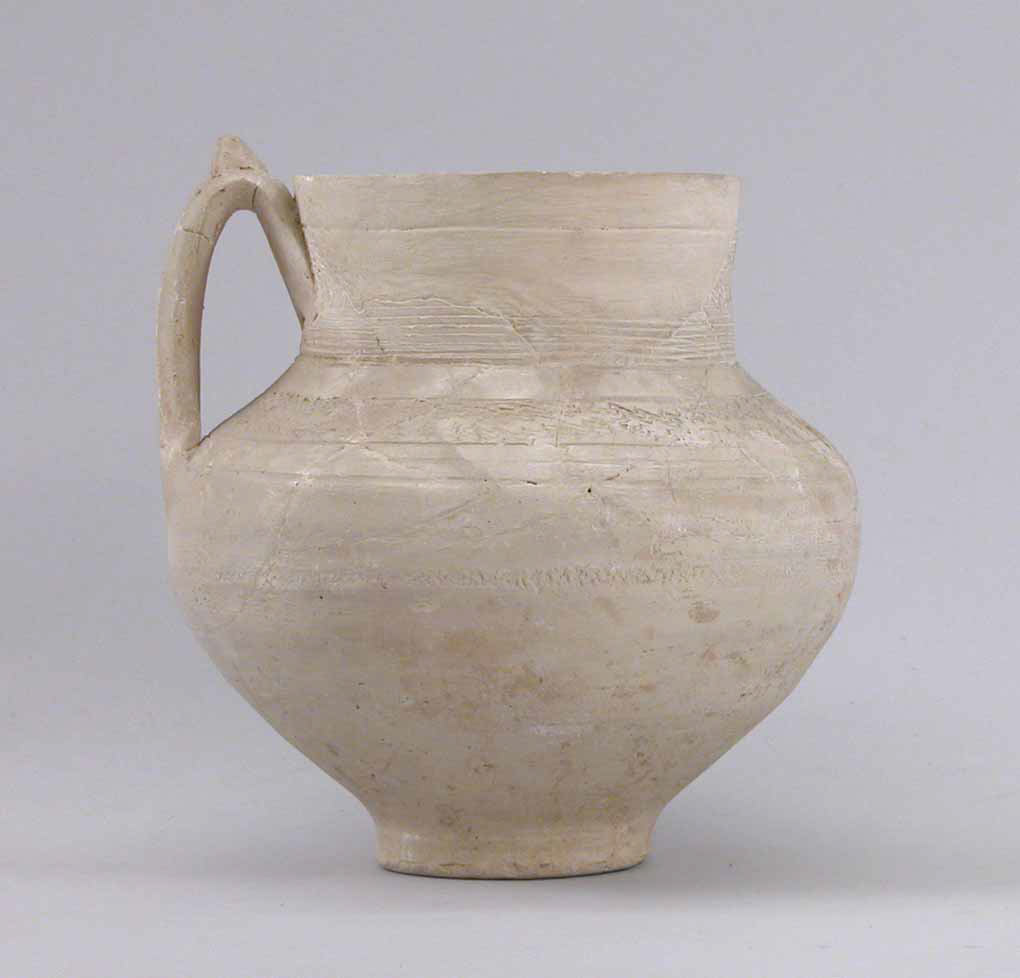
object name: jug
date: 801-1000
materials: earthenware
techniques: incising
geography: iran